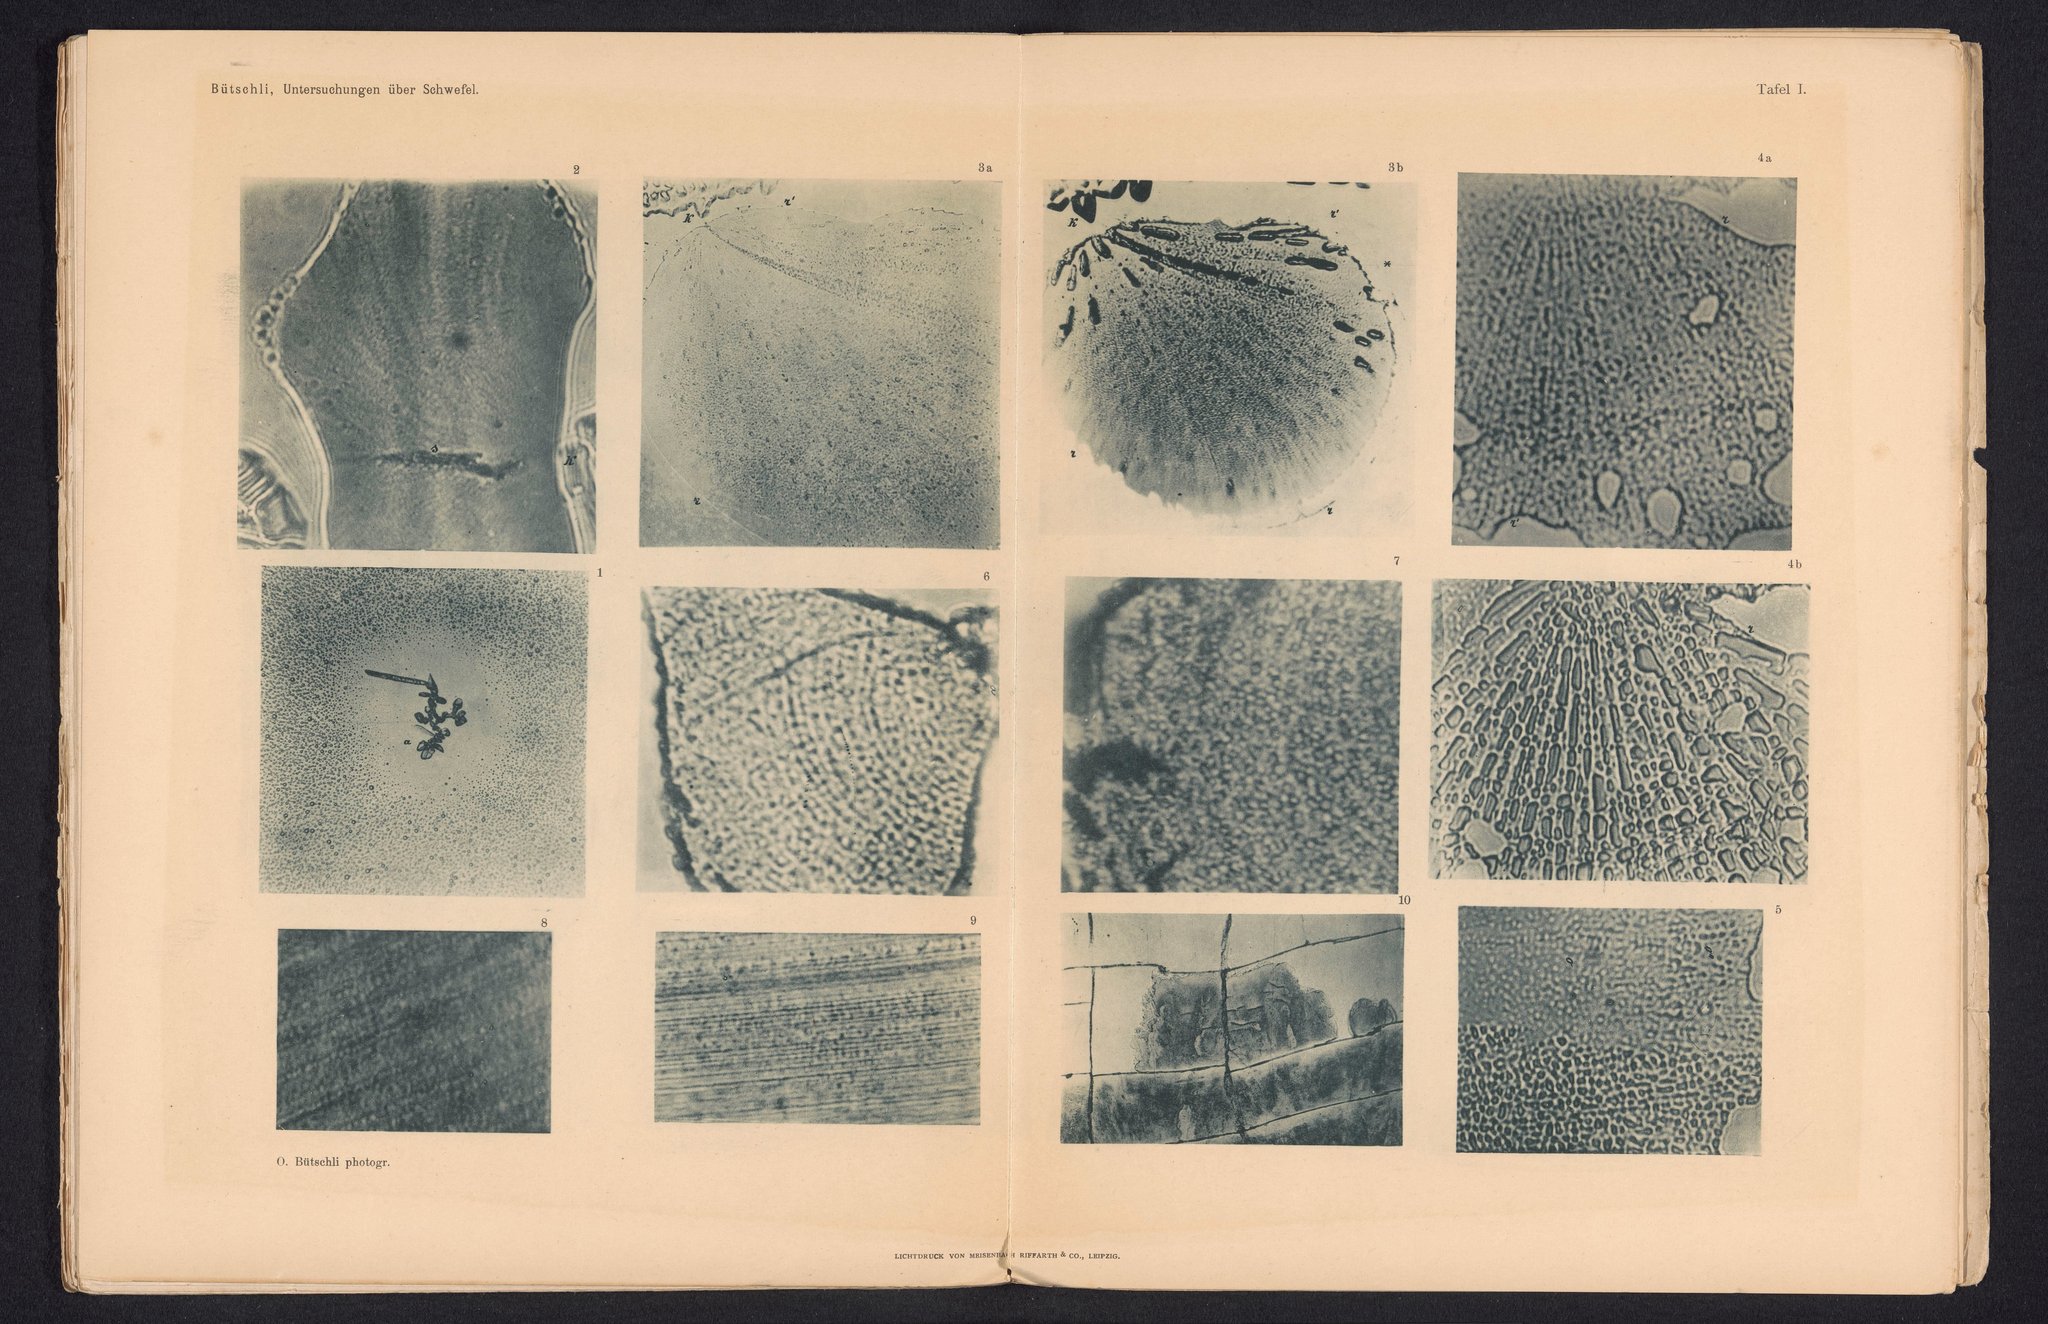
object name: page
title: Twaalf microscoopopnamen van gestolde zwavel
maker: otto bütschli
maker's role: fotograaf, professor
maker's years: 1848-1920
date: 1890-1900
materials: paper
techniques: photograph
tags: microscope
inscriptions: number: ‘Tafel I. 1 2 3a 3b 4a 4b 5 6 7 8 9 10’